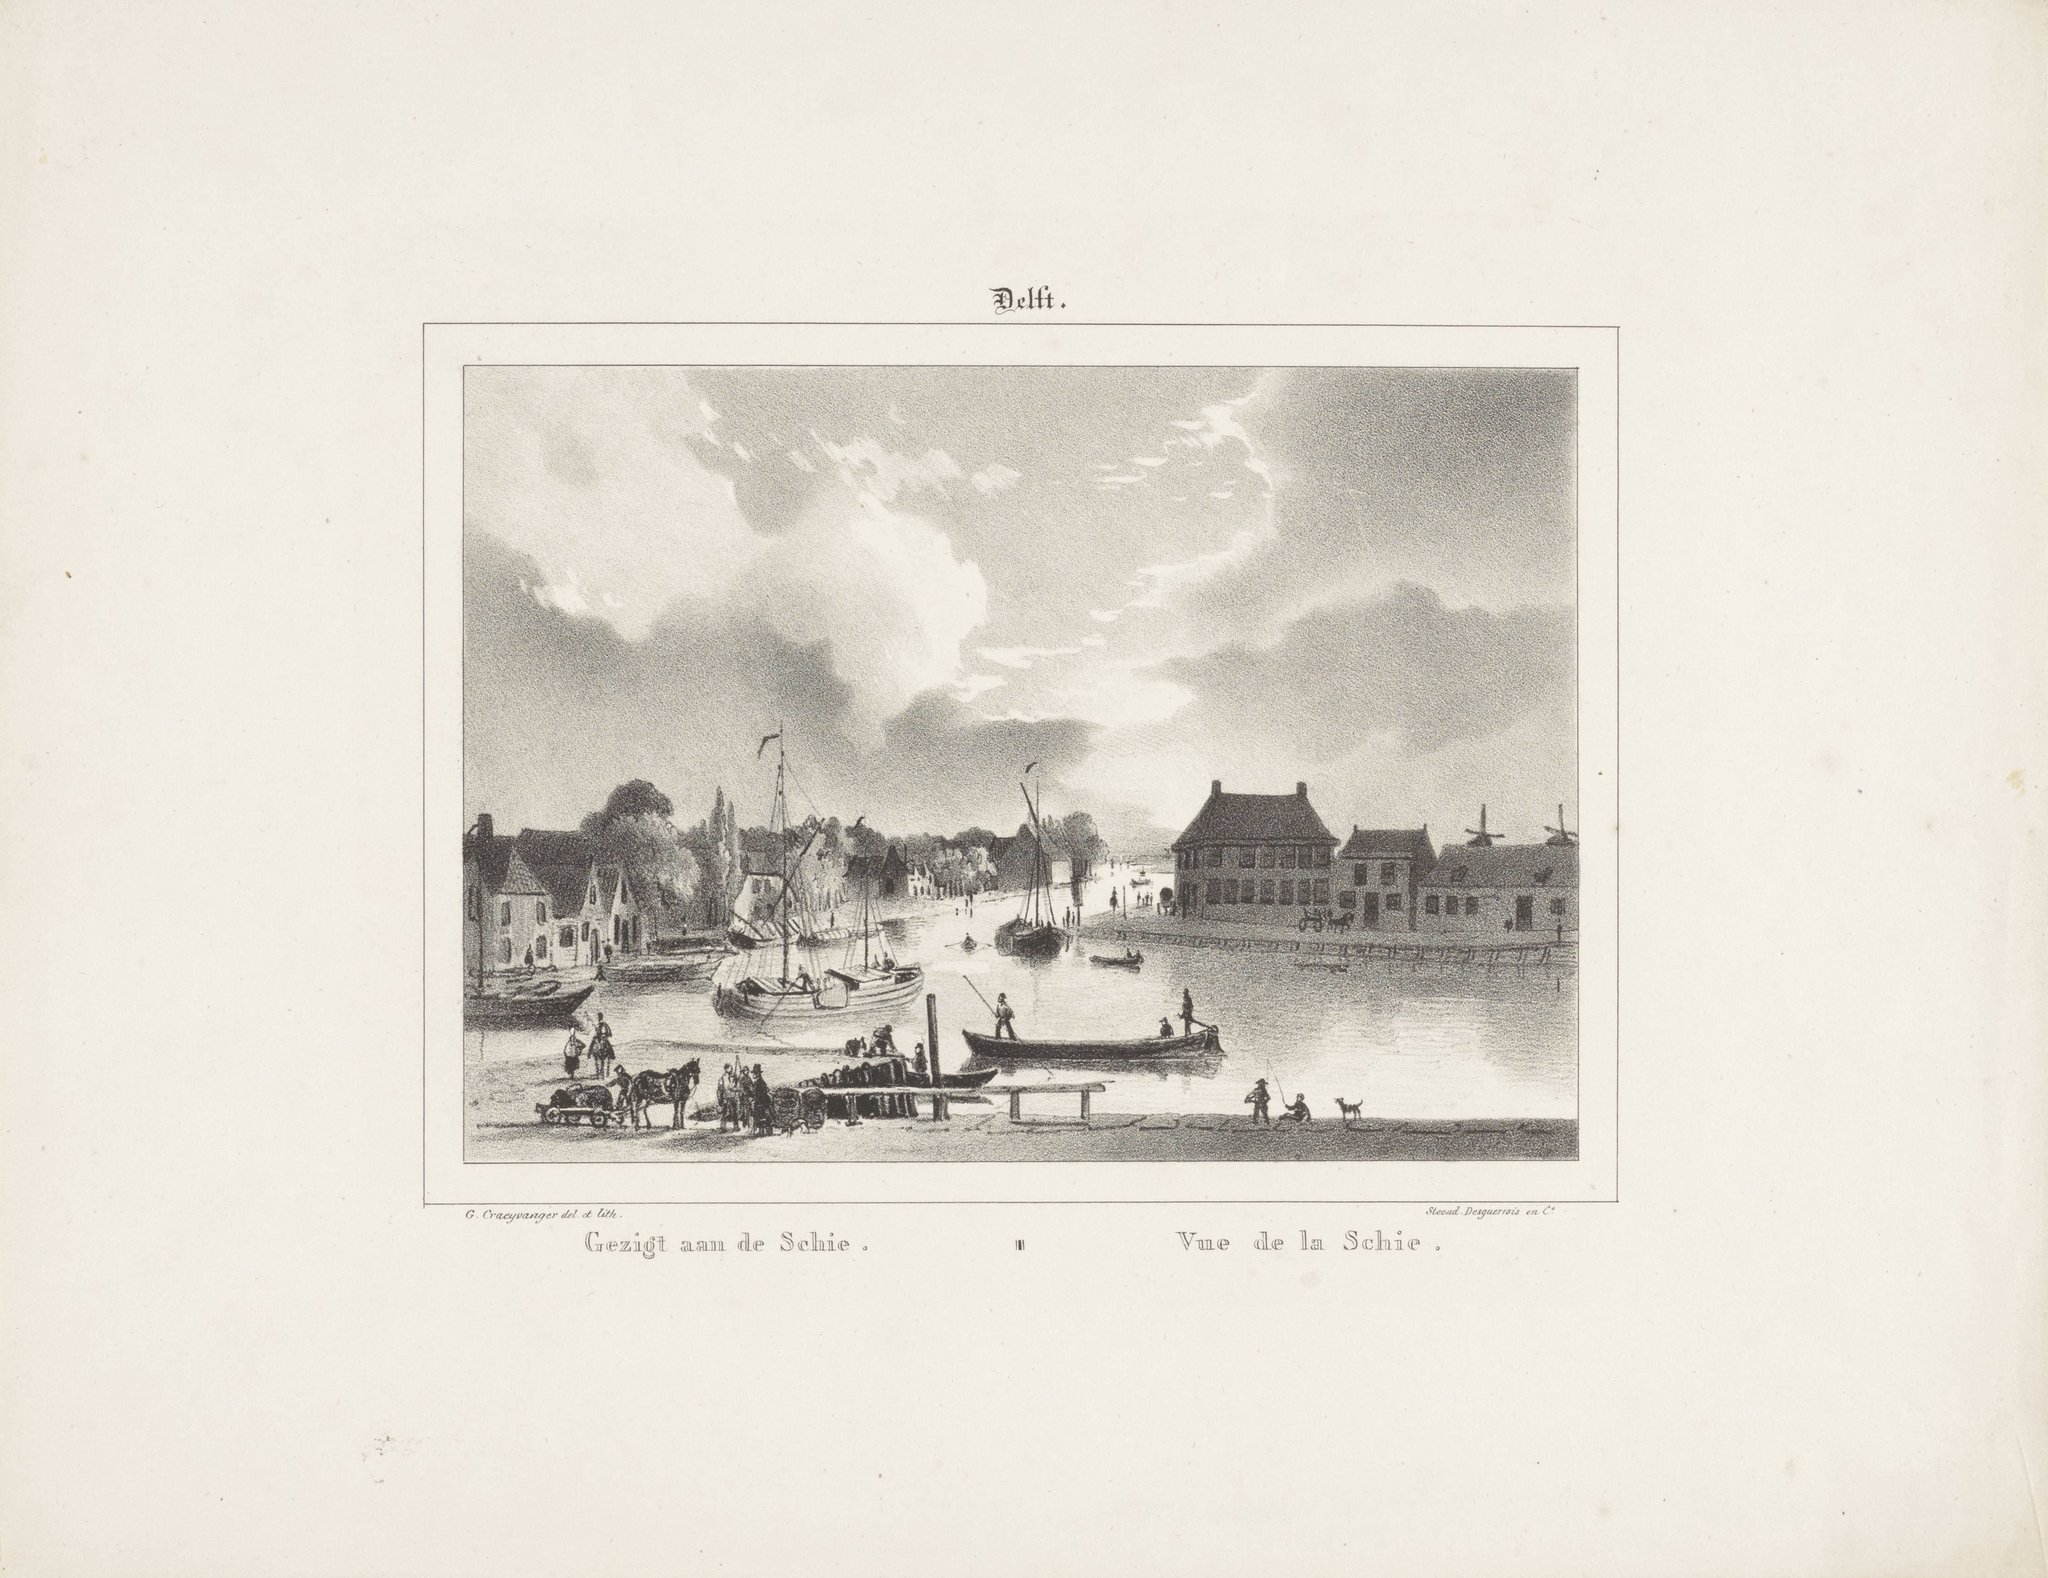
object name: print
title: Gezigt aan de Schie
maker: gijsbertus craeyvanger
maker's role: draughtsman, print maker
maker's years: 1810-1895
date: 1820-1895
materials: paper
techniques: lithograph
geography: amsterdam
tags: dry-dock, floating-dock (+ departure and arrival ~ traffic and transport), river (+ landscape with figures, staffage), city-view, and landscape with man-made constructions (+ city(-scape) with figures, staffage), delft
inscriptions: collector's mark: Lugt 2228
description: Op de kade staan figuren te wachten op een boot. Op de rivier varen grote en kleine zeil- en roeiboten.